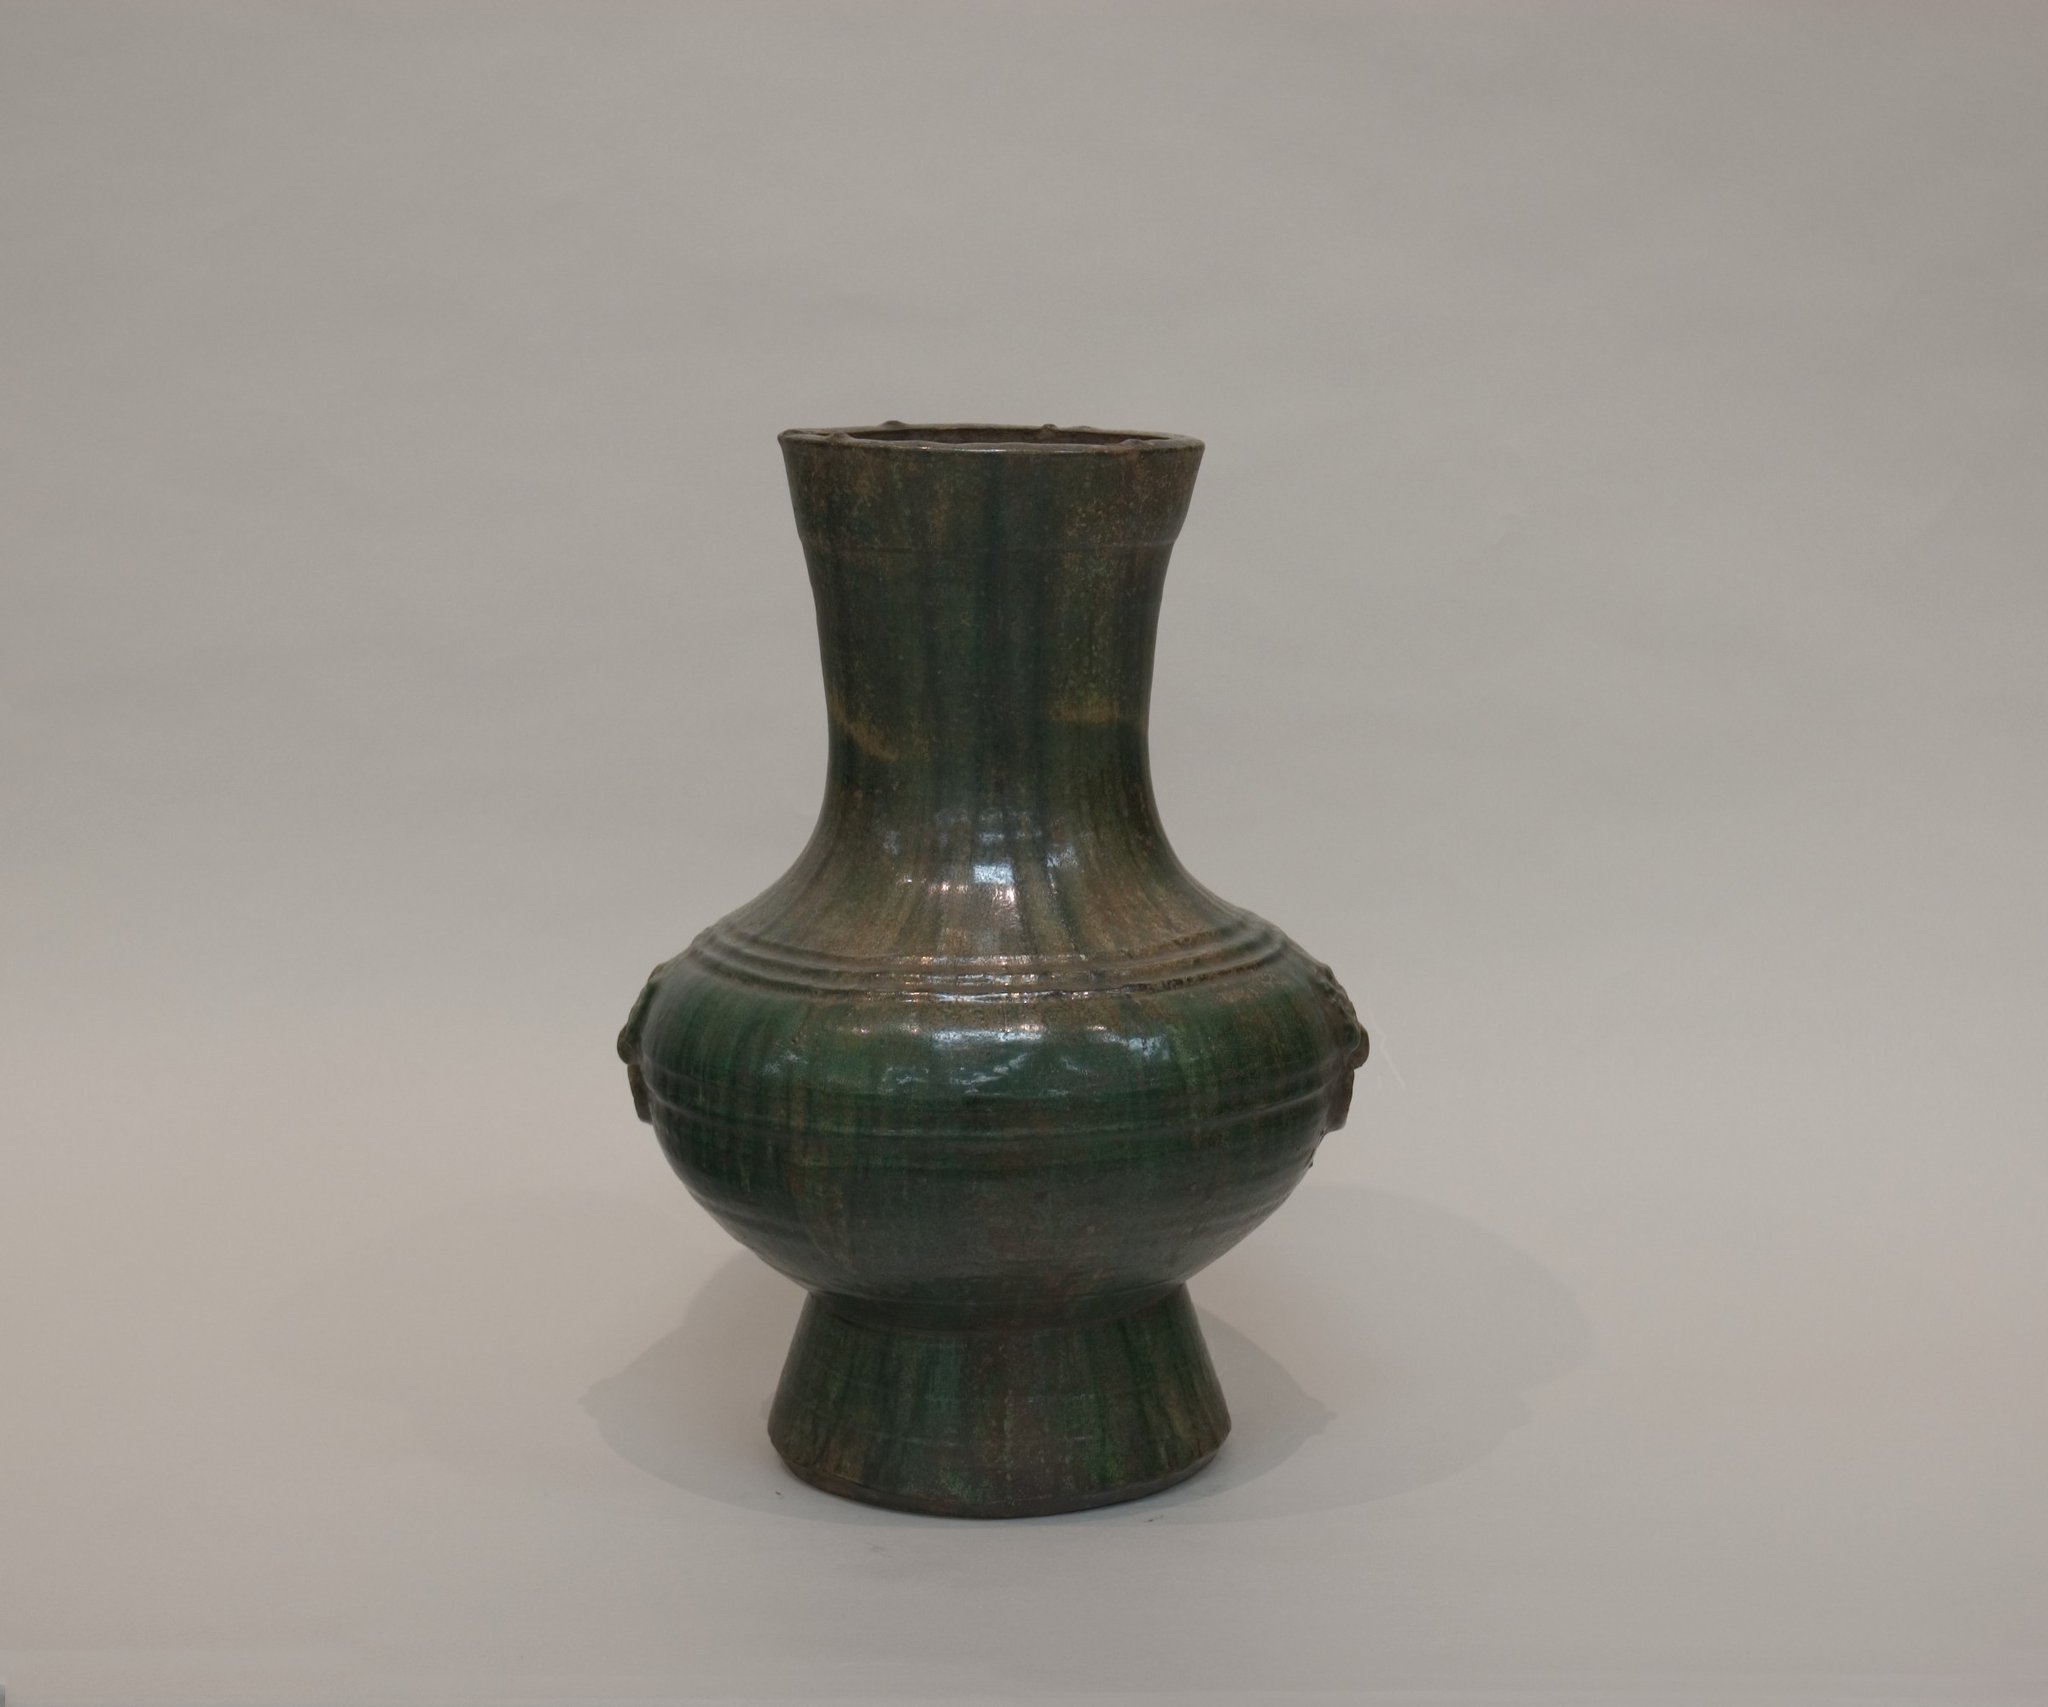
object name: vase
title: Wine container (hu)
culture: chinese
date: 1-200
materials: earthenware, glaze, lead